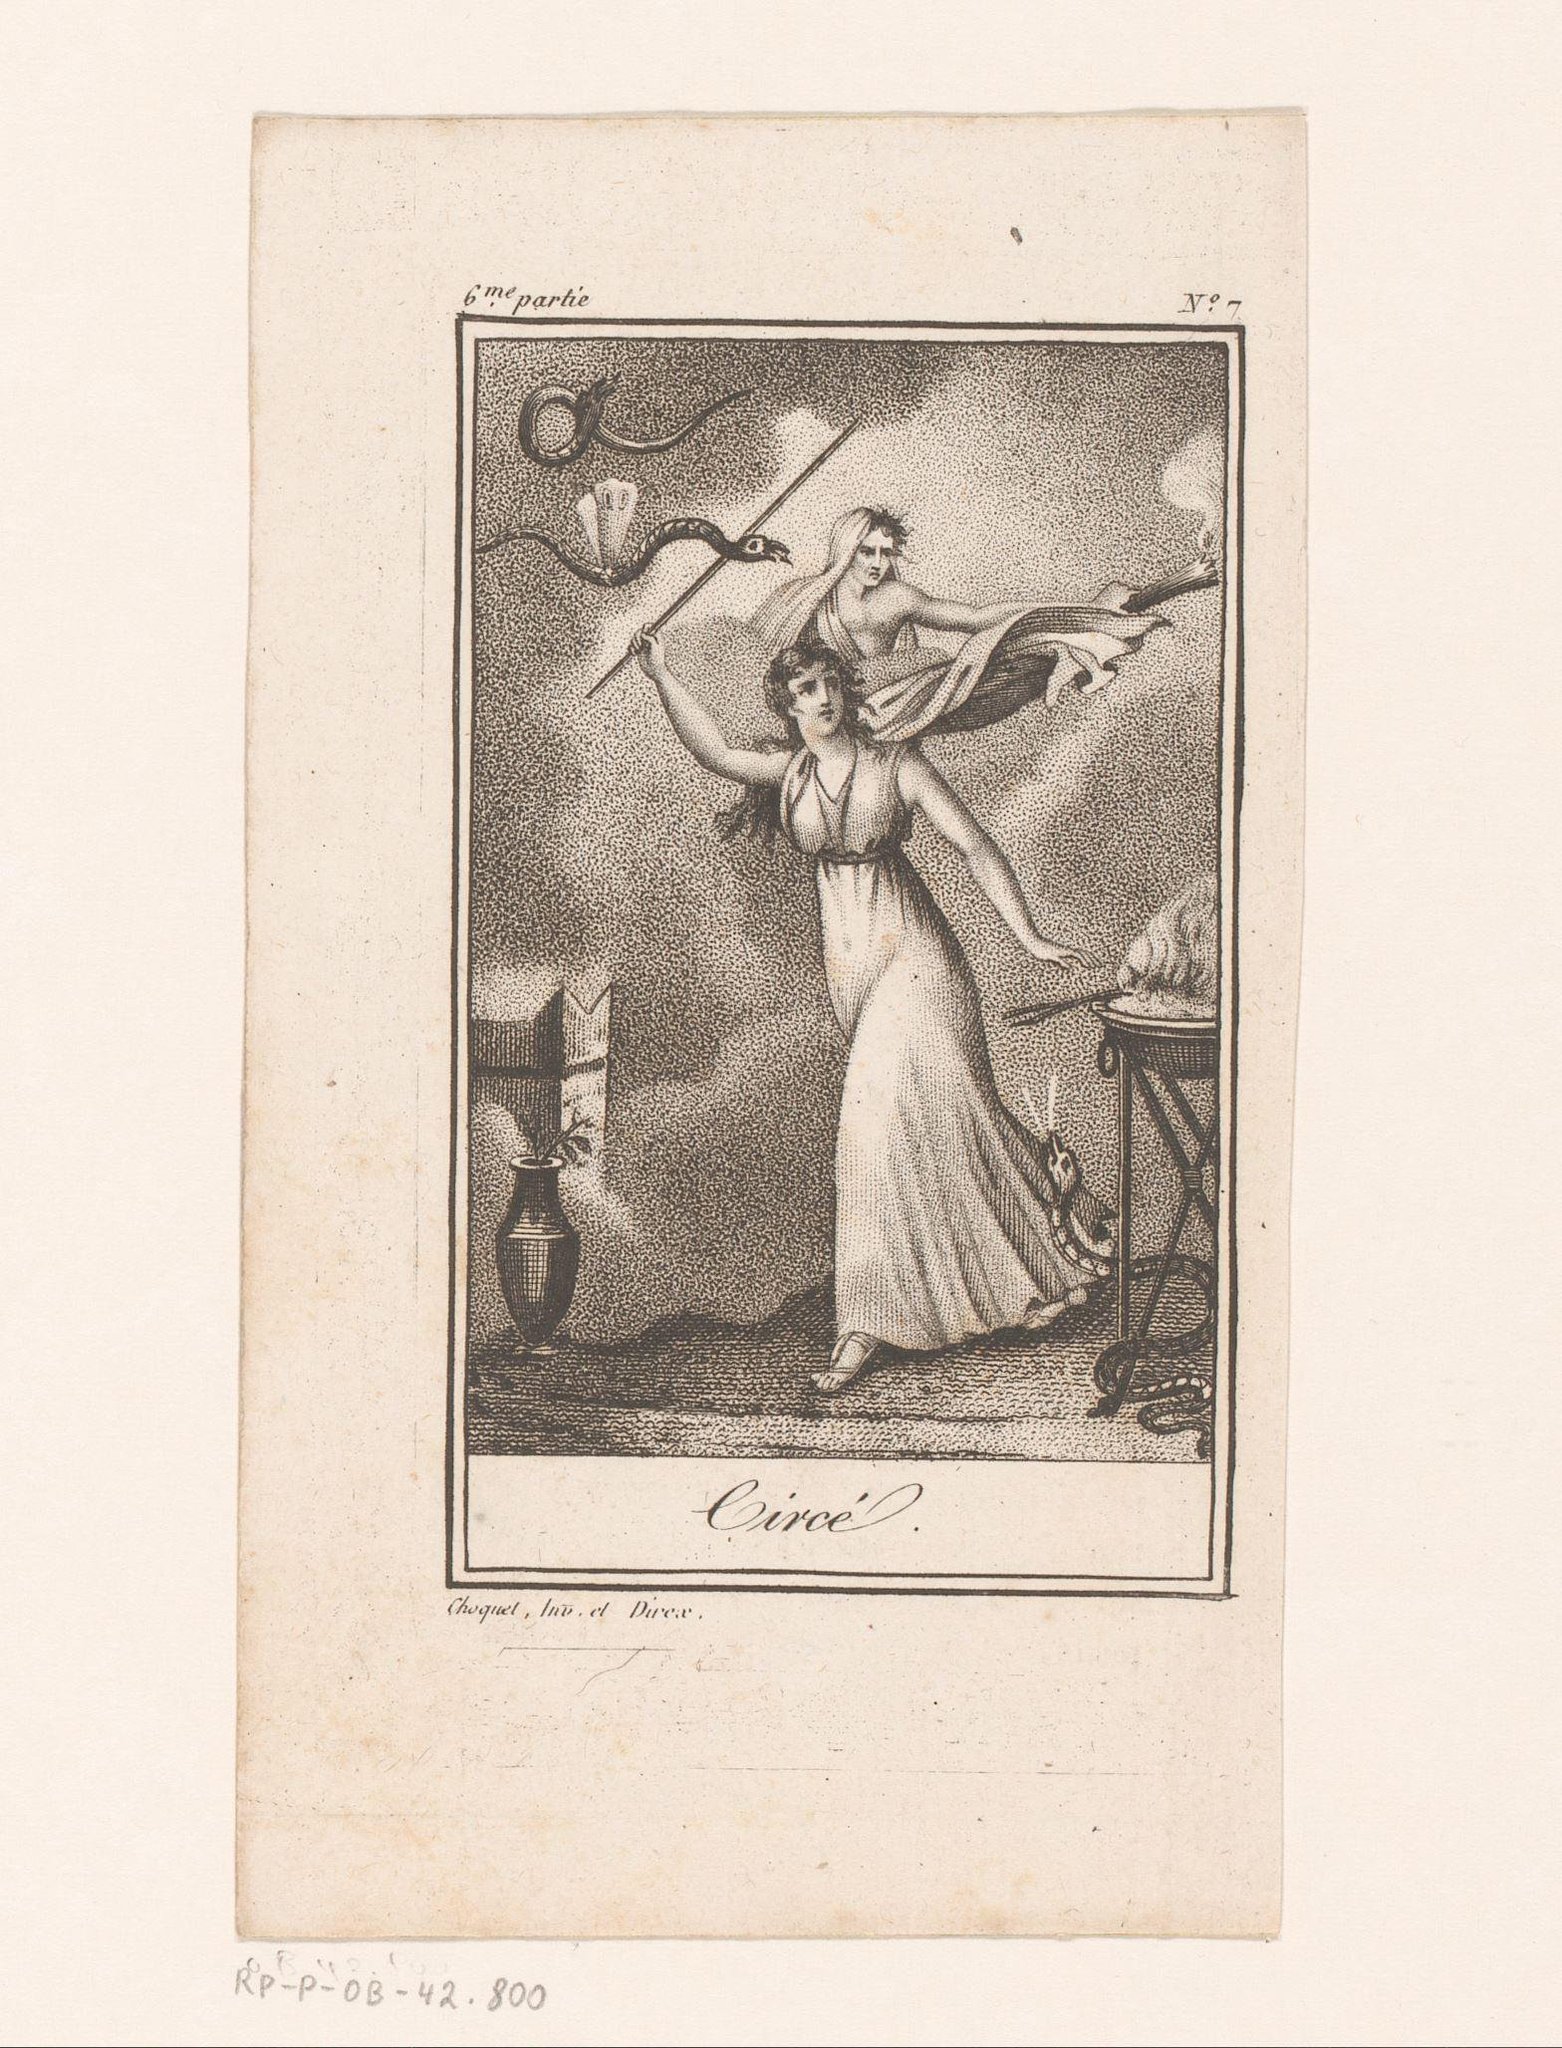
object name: print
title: Circé.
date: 1784-1824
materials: paper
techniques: engraving, etching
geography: france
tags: circe - attributes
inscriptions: collector's mark: Lugt 2228